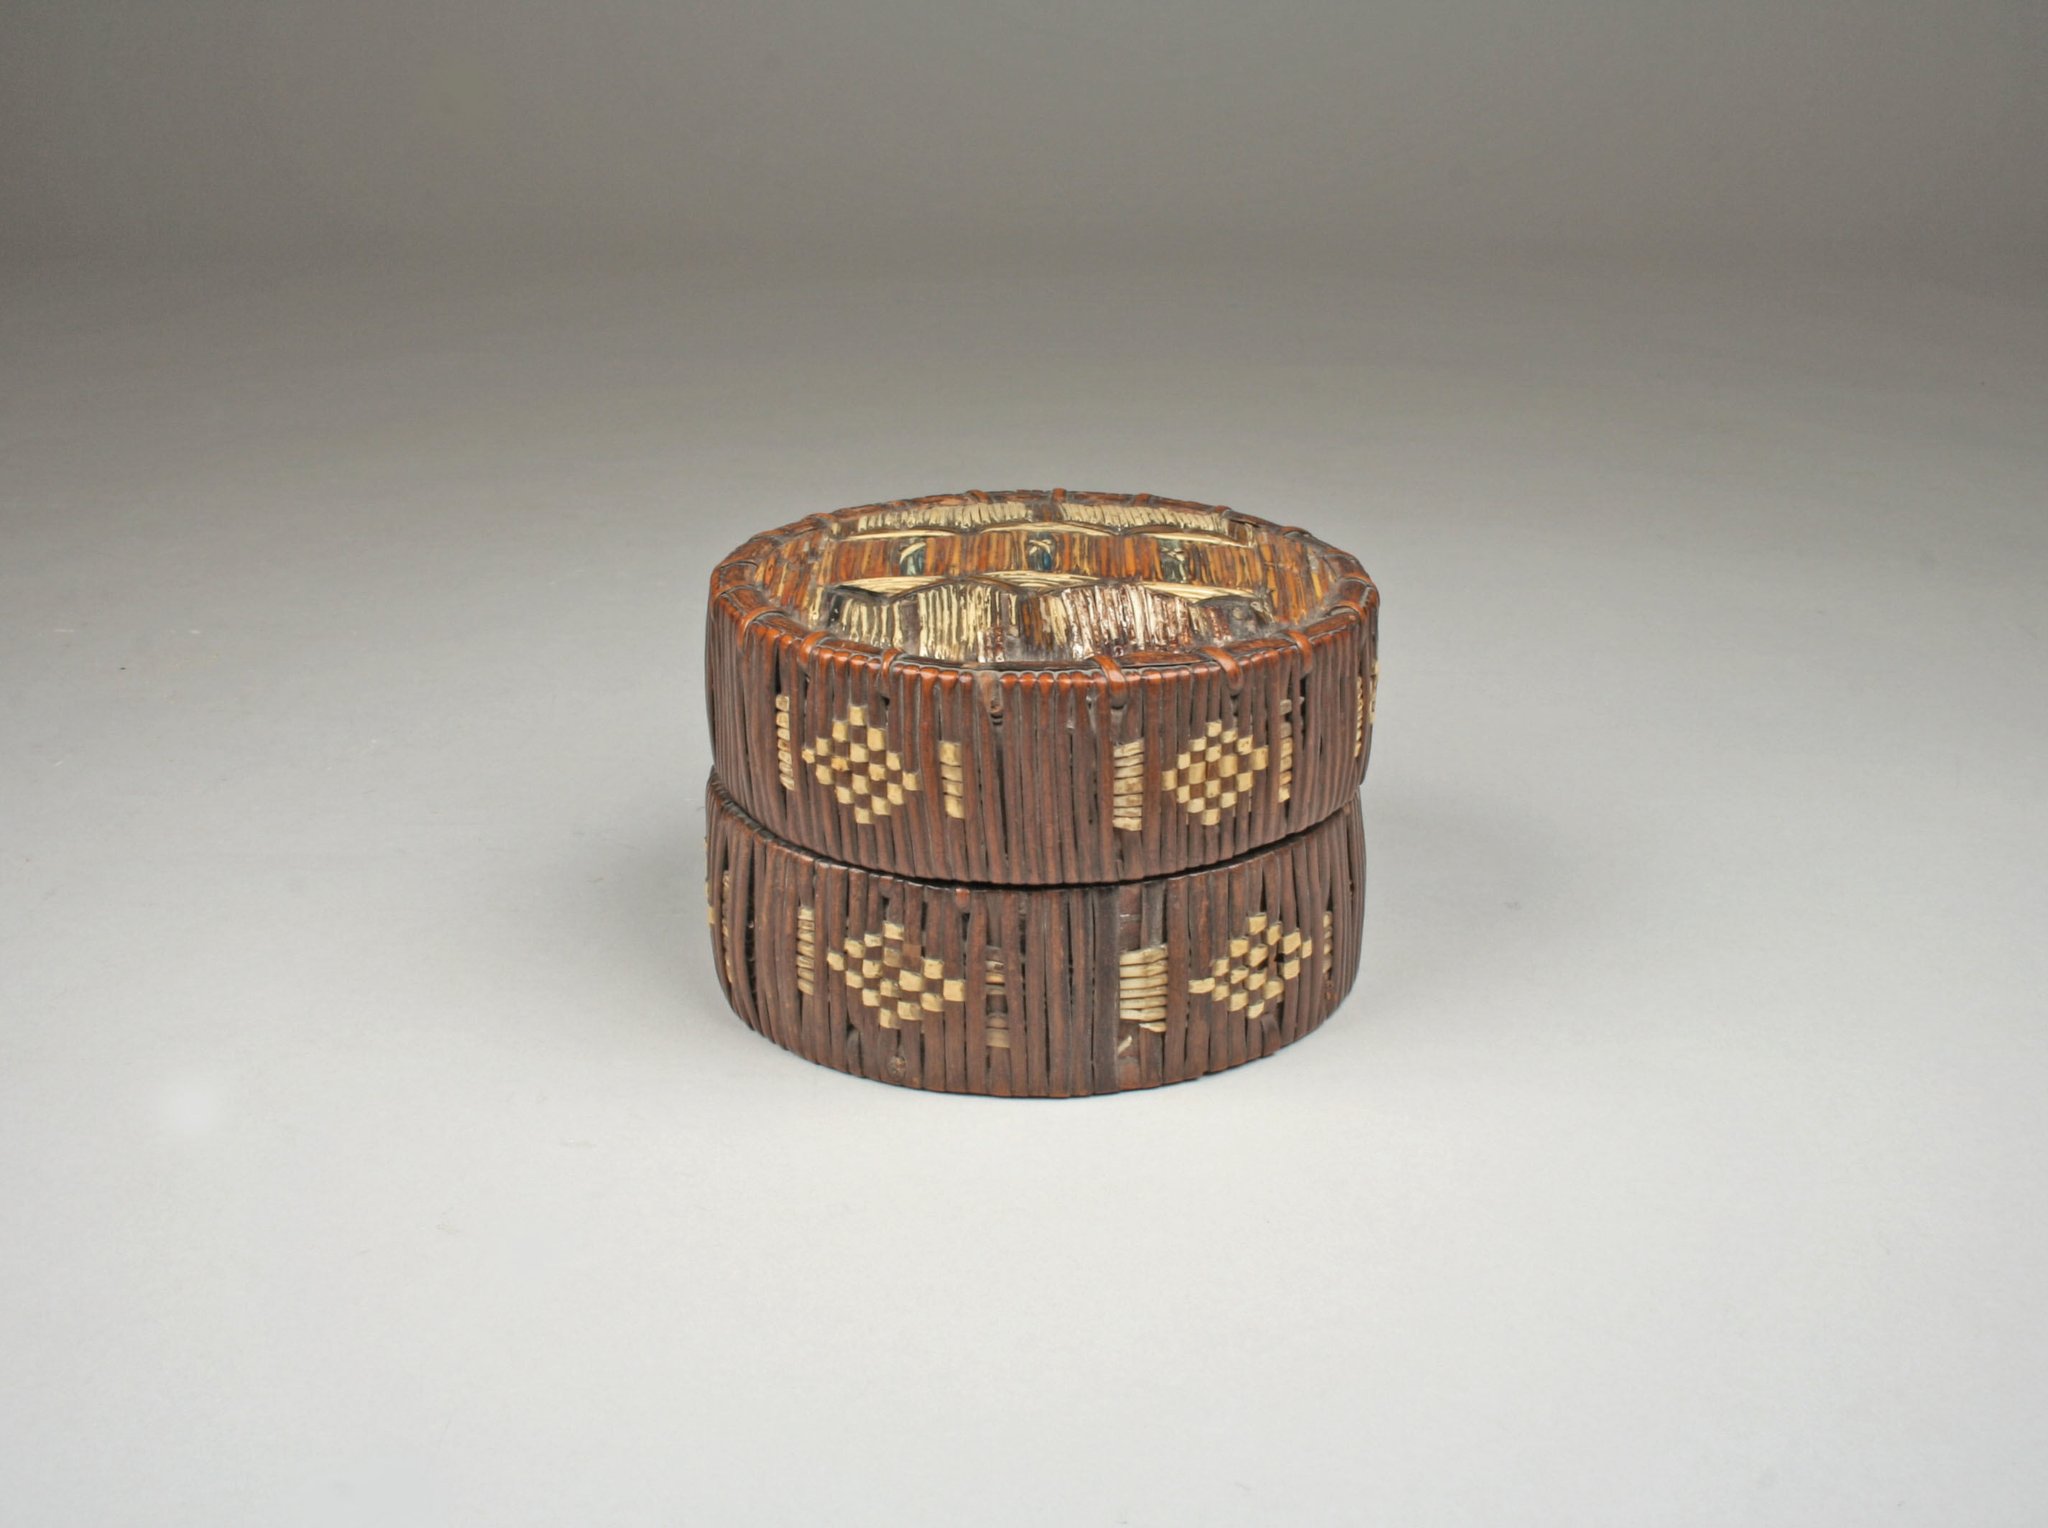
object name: box with lid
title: Lidded Box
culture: micmac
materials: wood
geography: canada